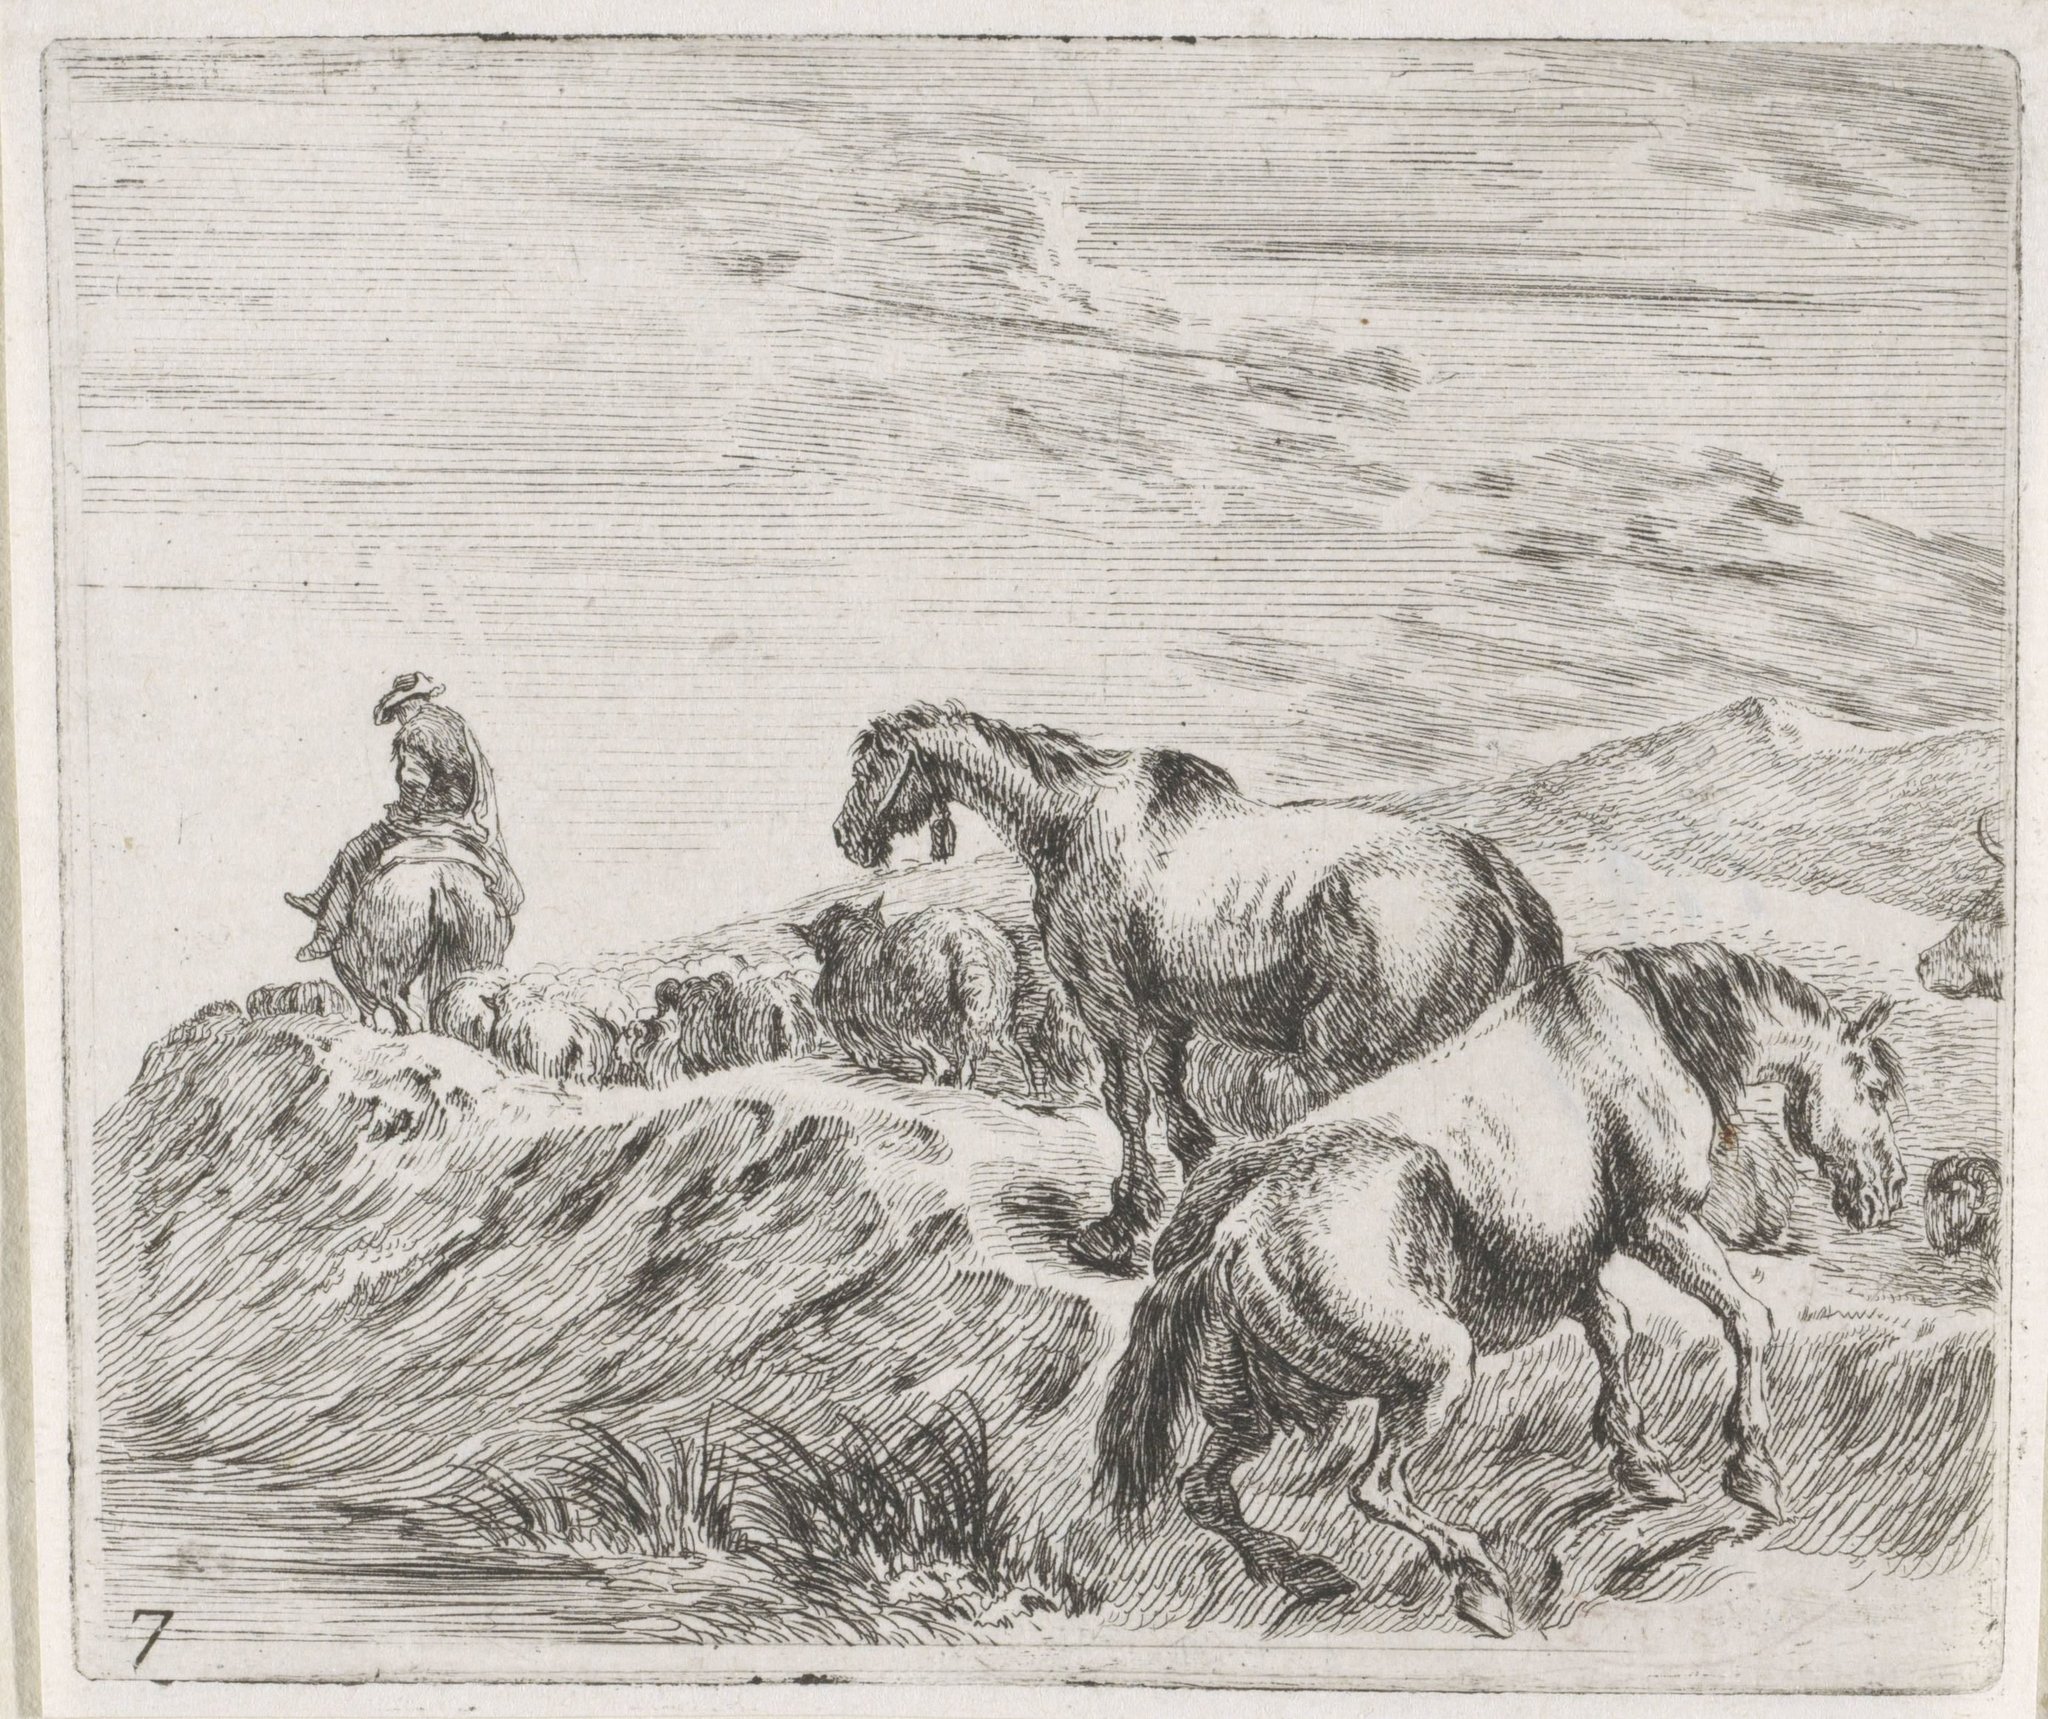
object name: print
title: Diversi capricci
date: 1632-1664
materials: paper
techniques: etching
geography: paris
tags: herding, herdsman, herdswoman, shepherd, shepherdess, cowherd, etc., sheep, horse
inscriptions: collector's mark: Lugt 240